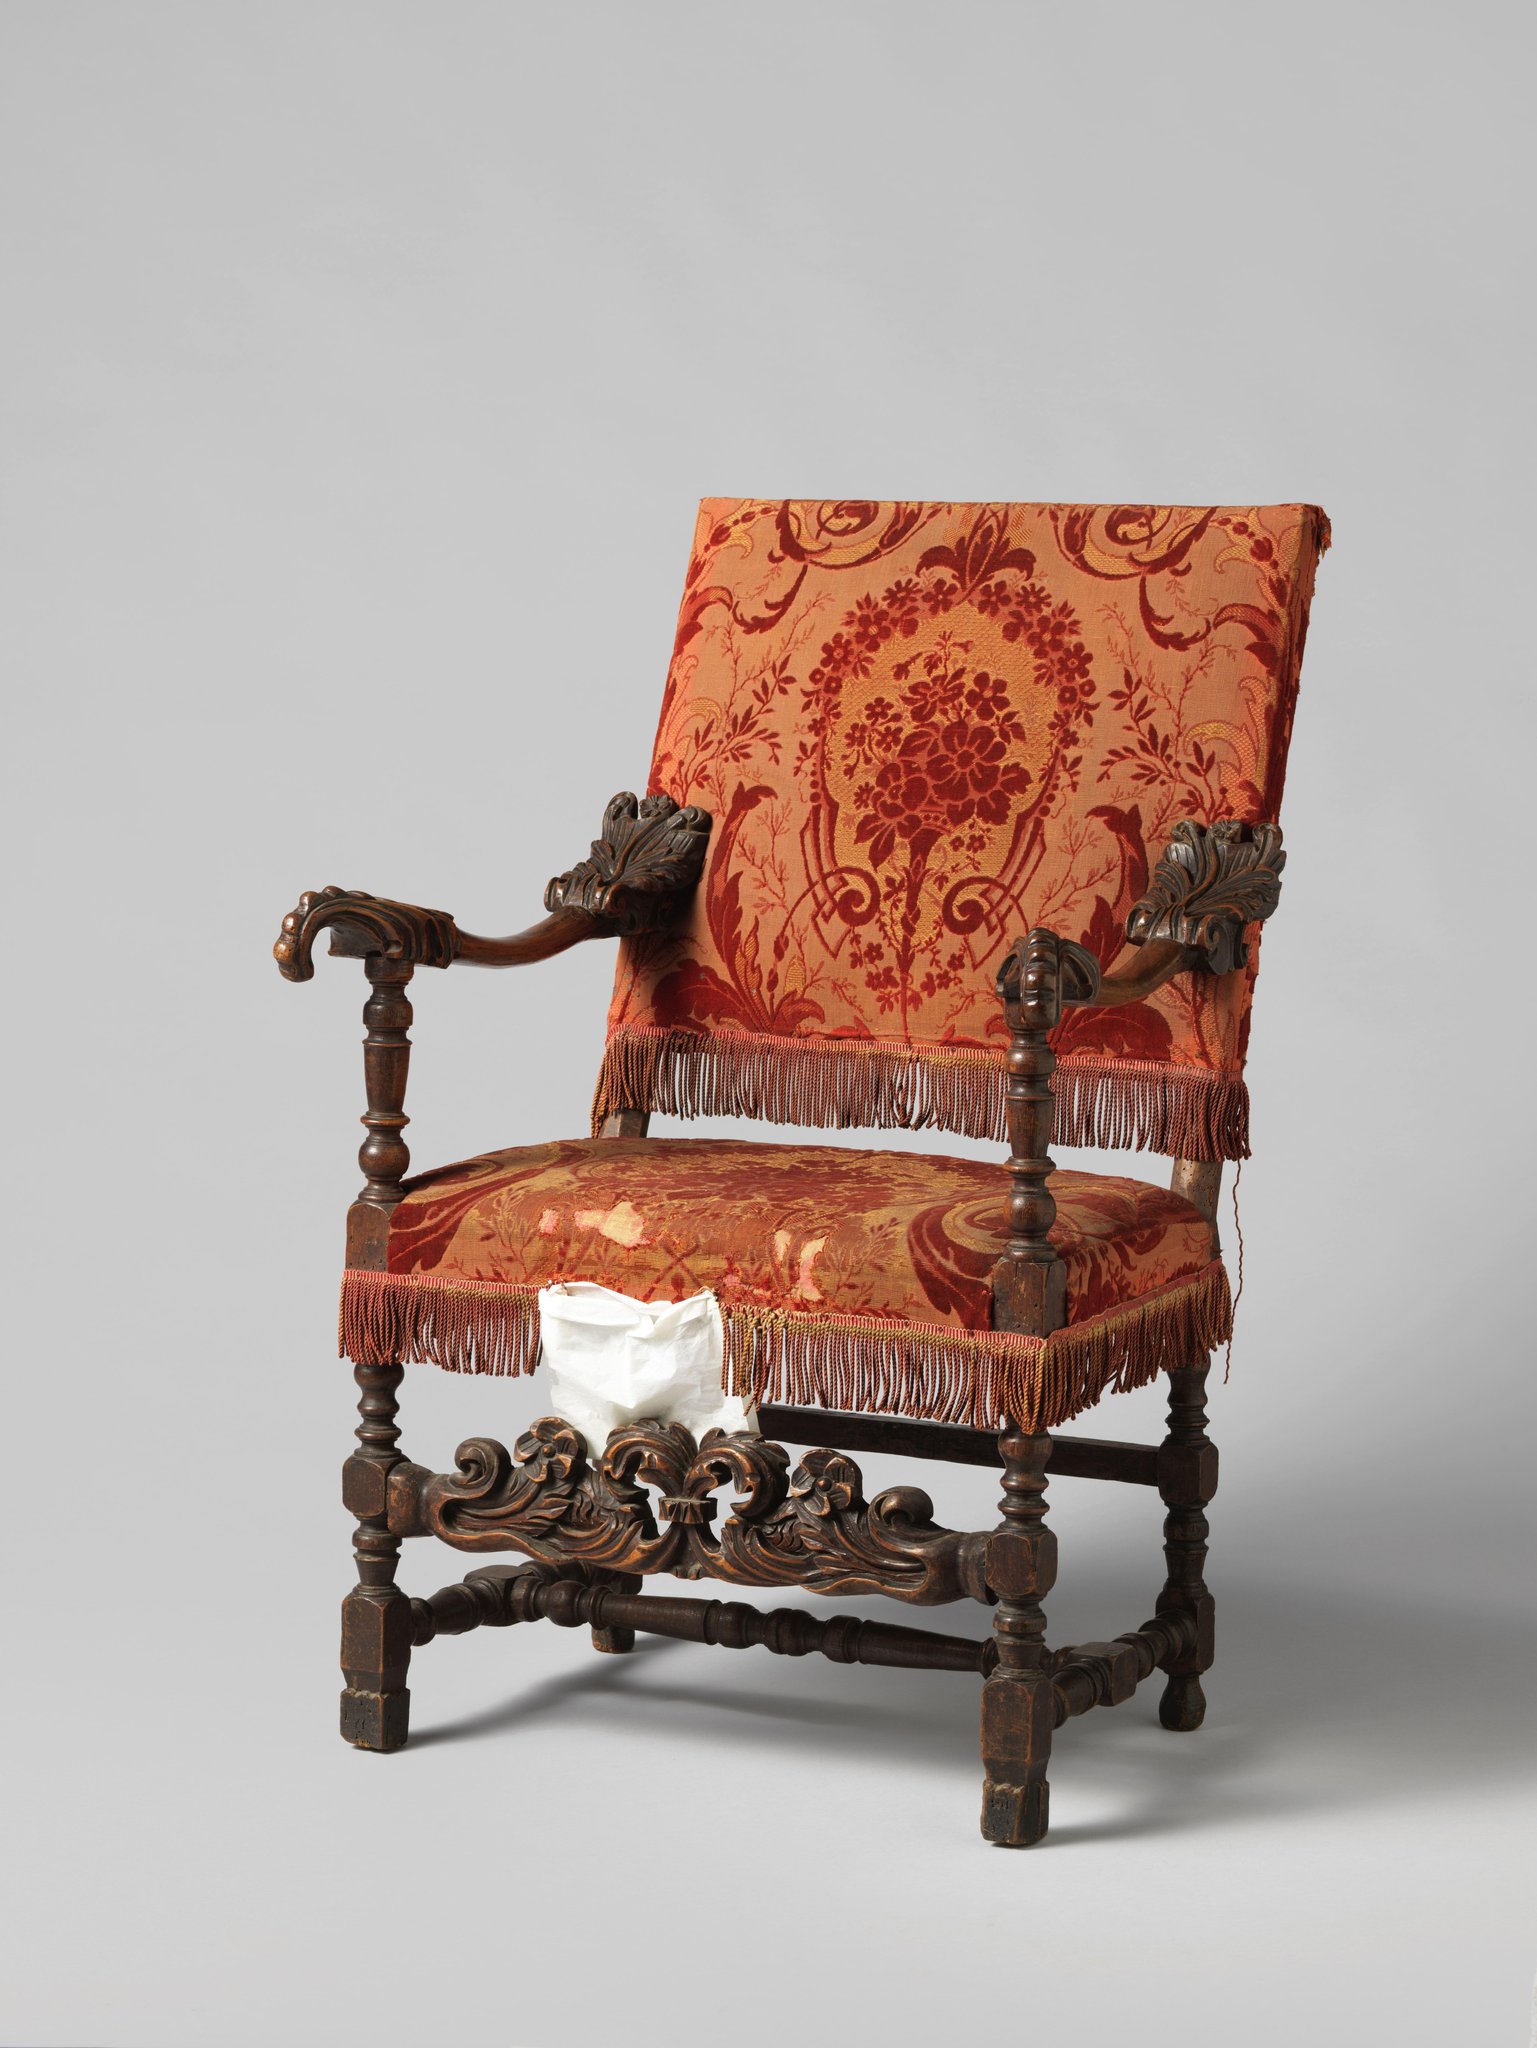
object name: armchair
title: Armstoel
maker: Anonymous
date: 1700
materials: velvet, wood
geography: italy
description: Armstoel van notenhout, bekleed met modern rood geperst fluweel met bloemmotieven. Het meubel rust op poten met huis en geleding, verbonden door een H-vormig kruis. Aan de voorzijde is een sport met een groot acanthusblad aangebracht. De eveneens gelede armleggerstutten steunen de licht geholde, aan de voorzijde naar buitenwijkende armleggers, eindigend in gestoken bladmotieven.